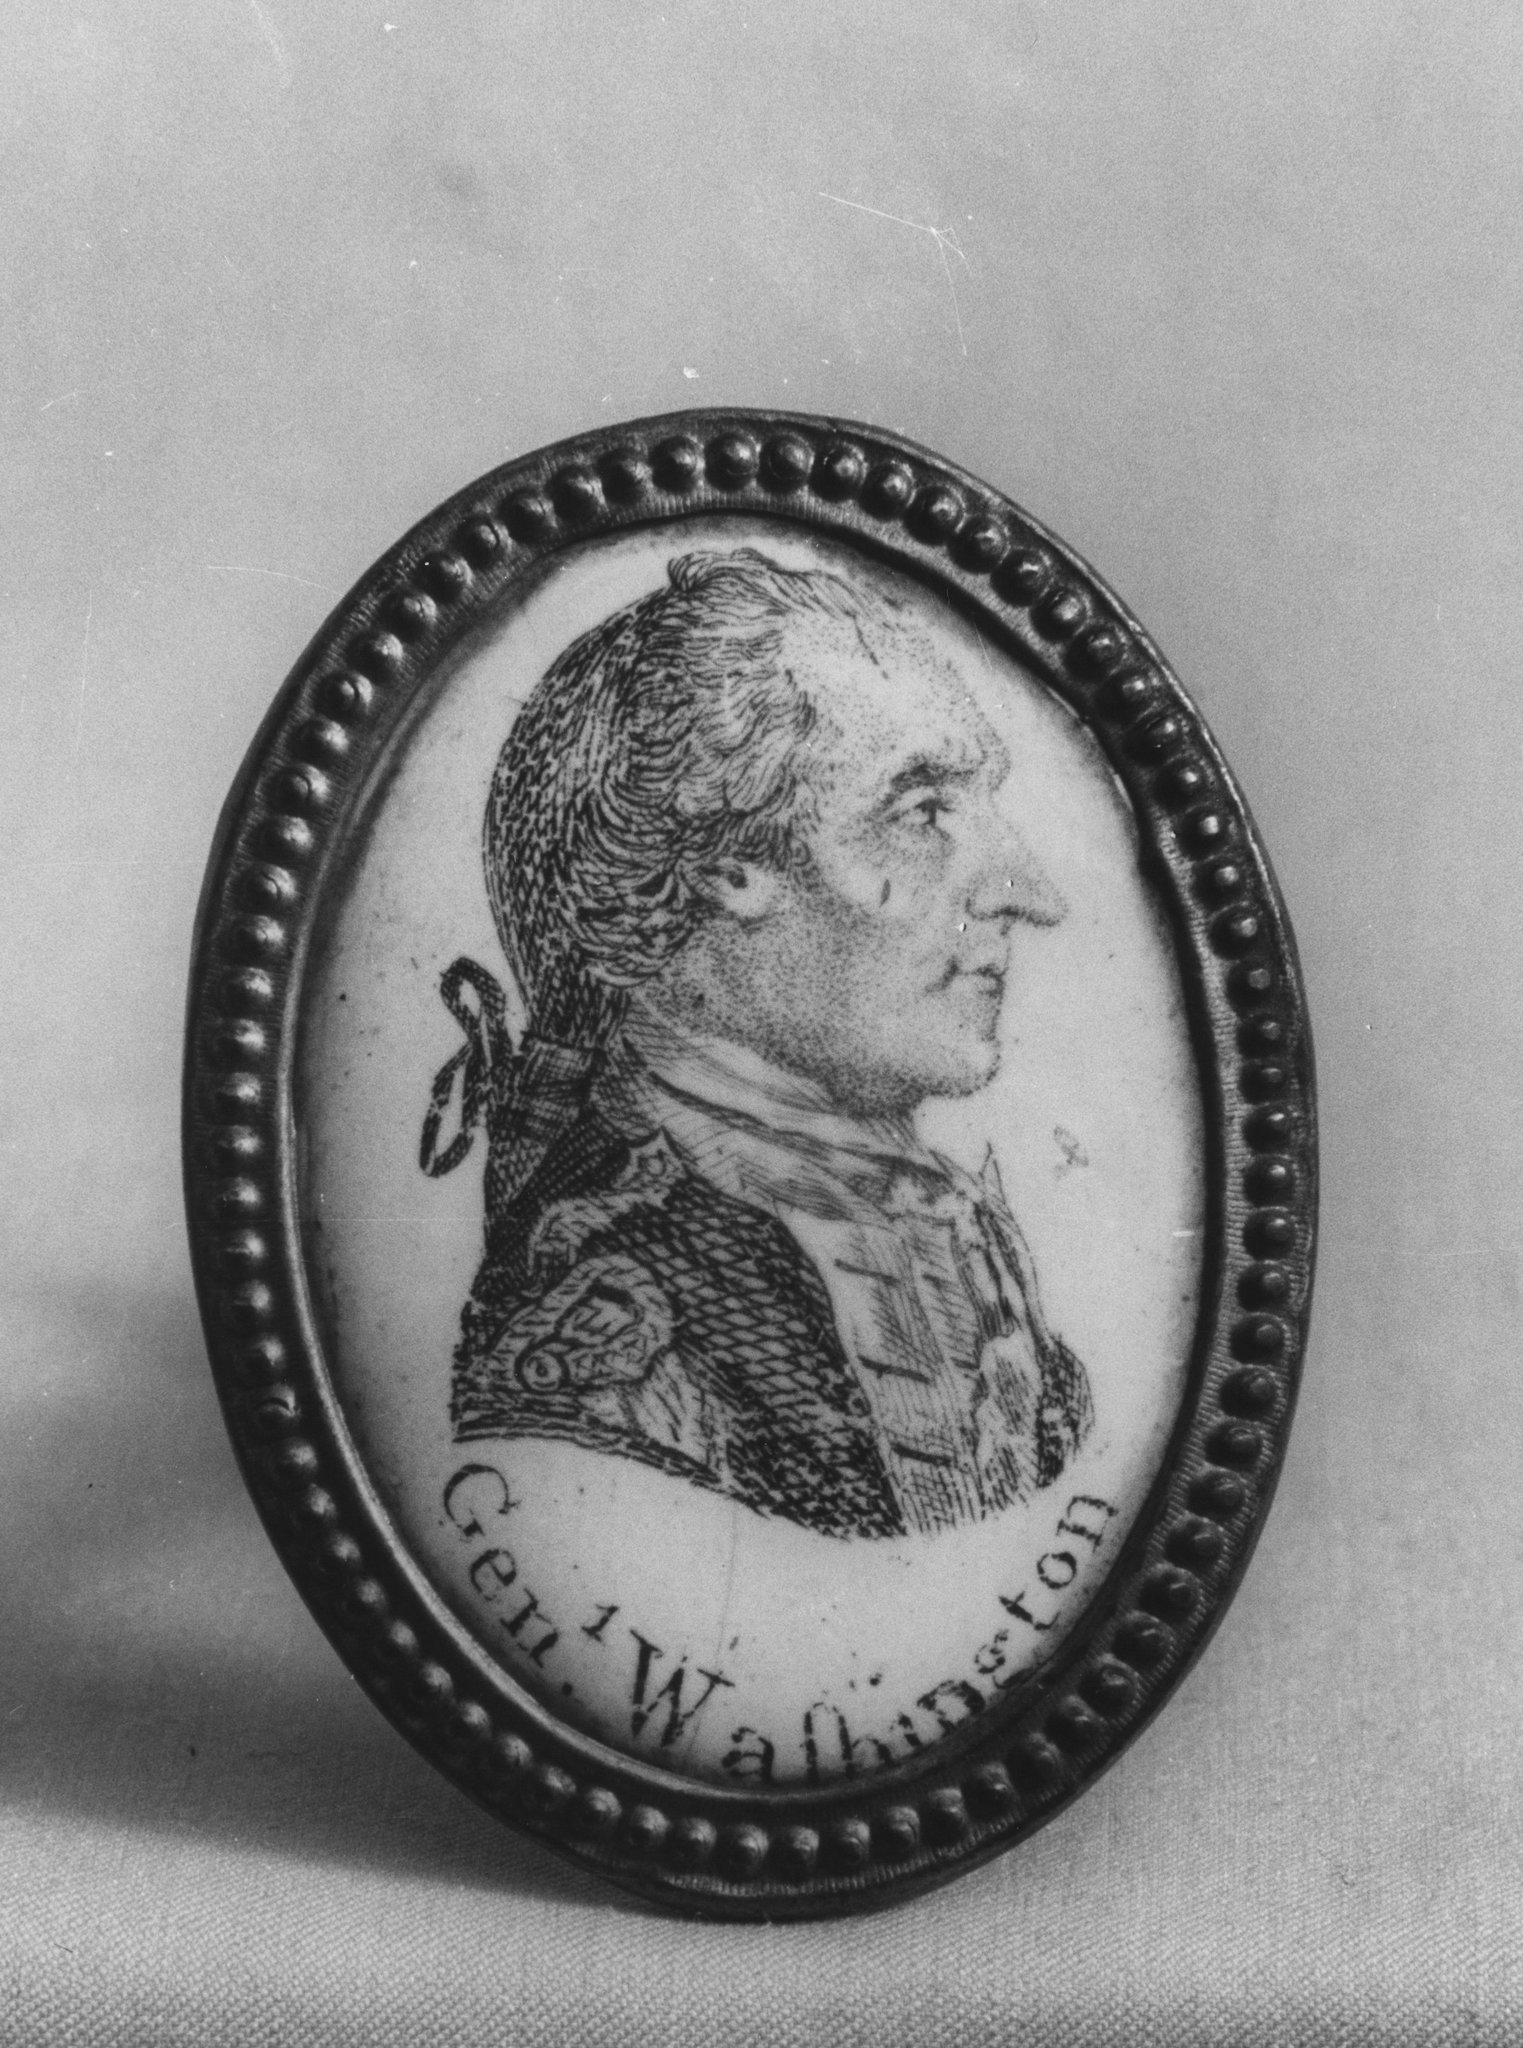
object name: pin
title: Cloak Pin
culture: british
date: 1770-1800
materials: brass, enamel, gilt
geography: england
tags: george washington,profiles